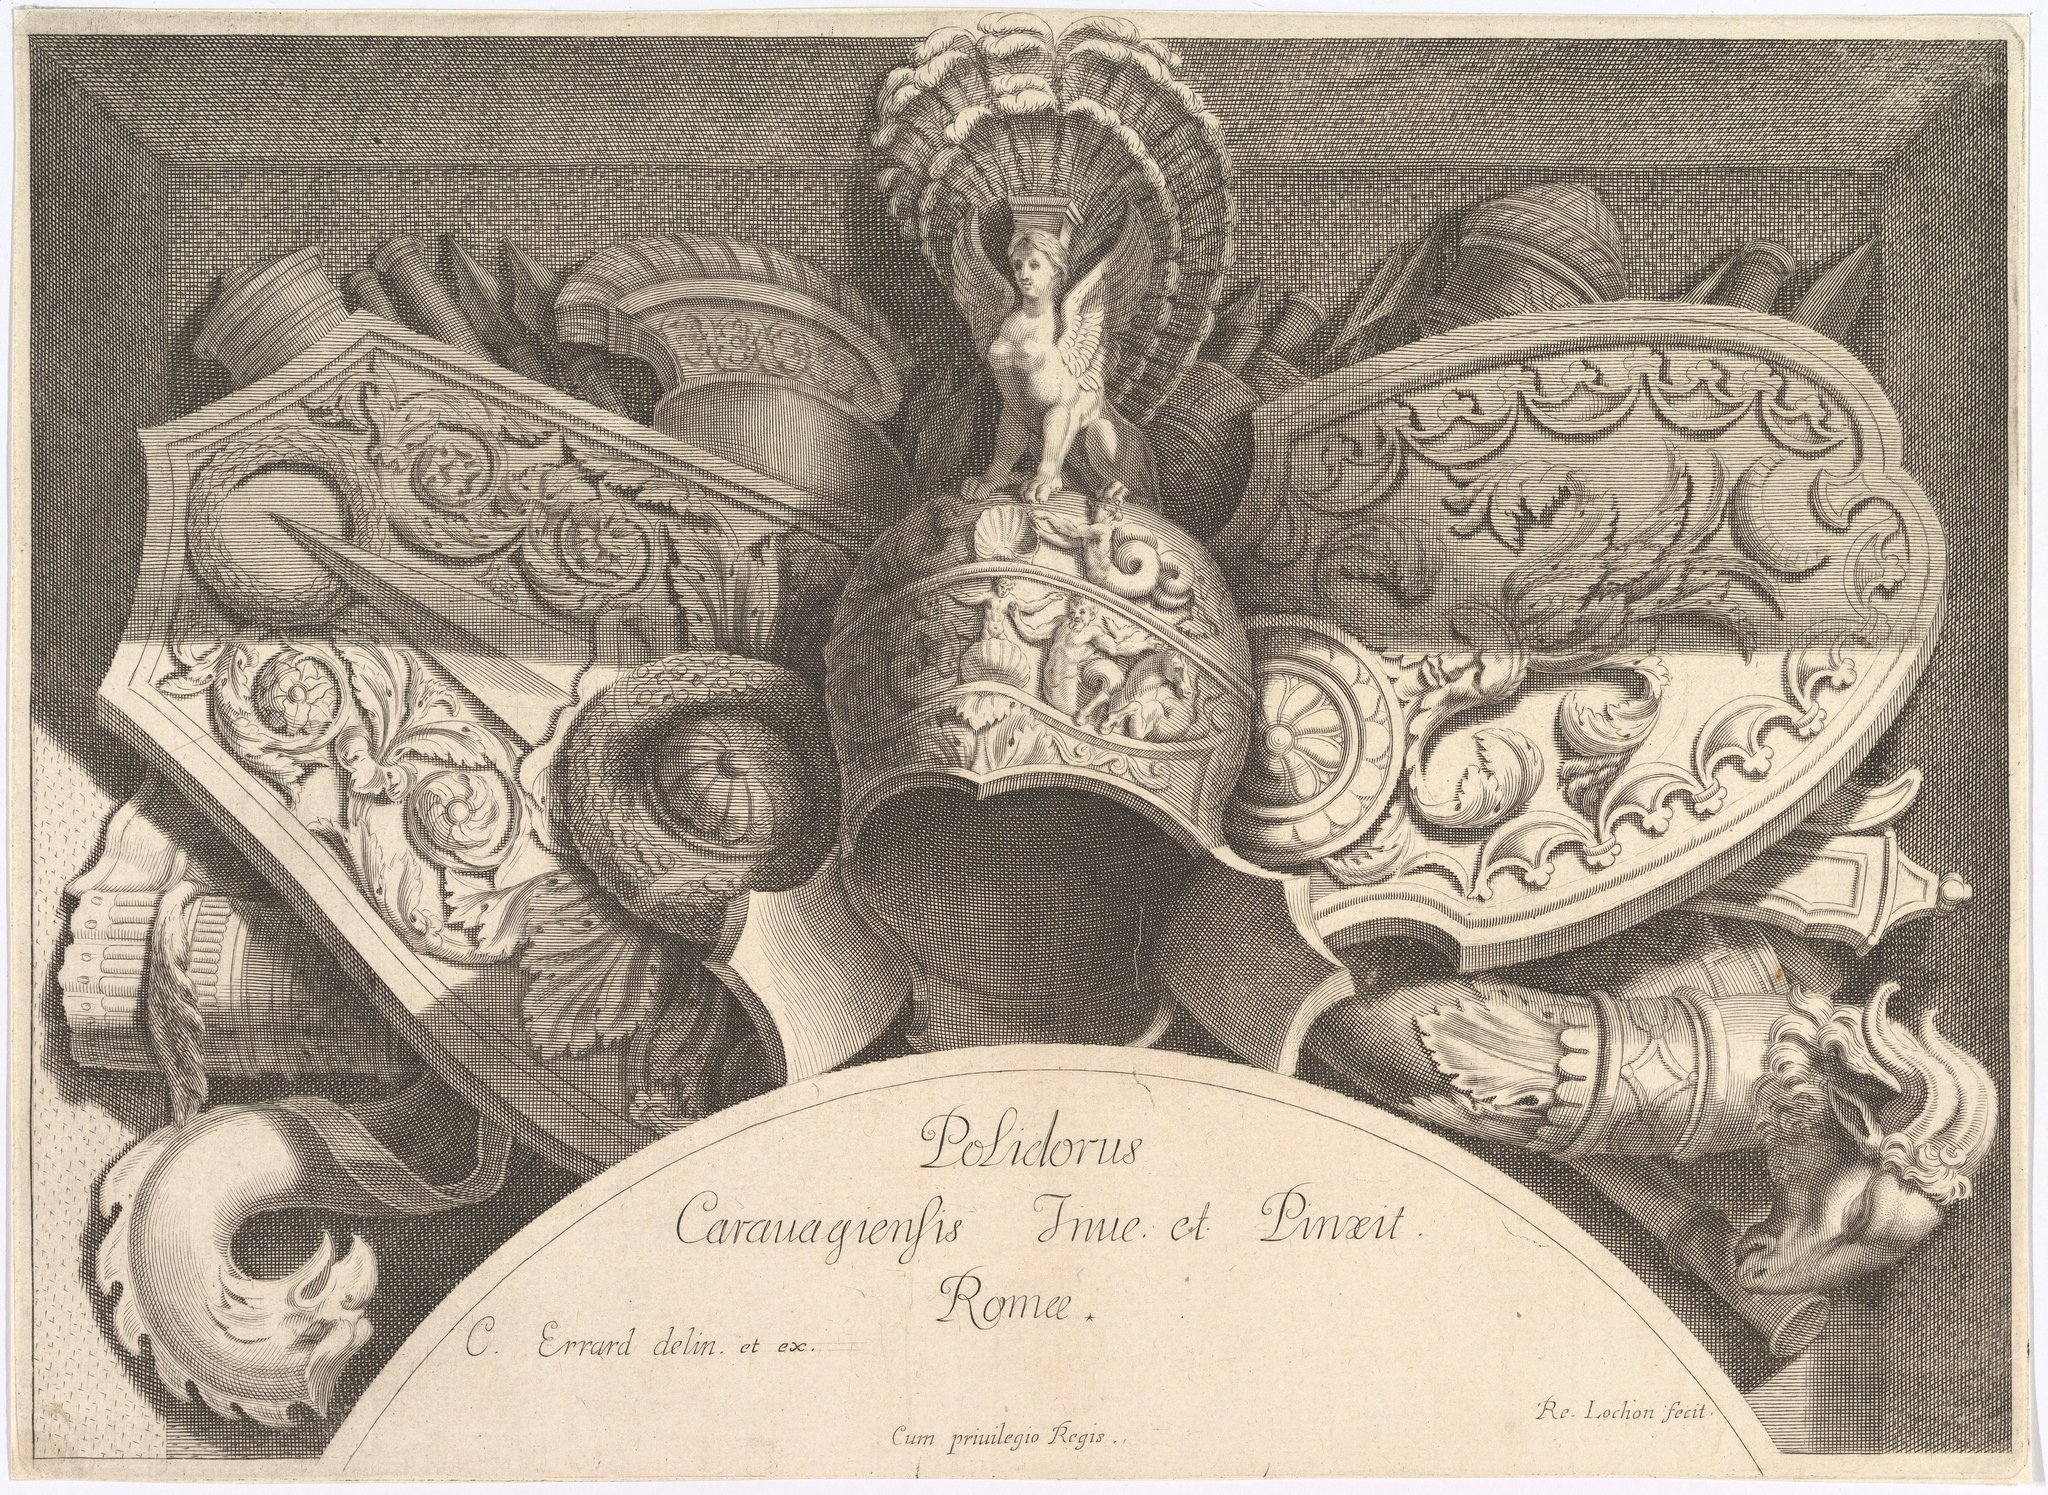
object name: print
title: Plate from "Divers Trophées" (Weapon Trophies after the Façade of Palazzo Milesi in Rome)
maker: polidoro da caravaggio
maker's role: artist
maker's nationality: italian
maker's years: 1494-1548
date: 1651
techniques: engraving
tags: trophies